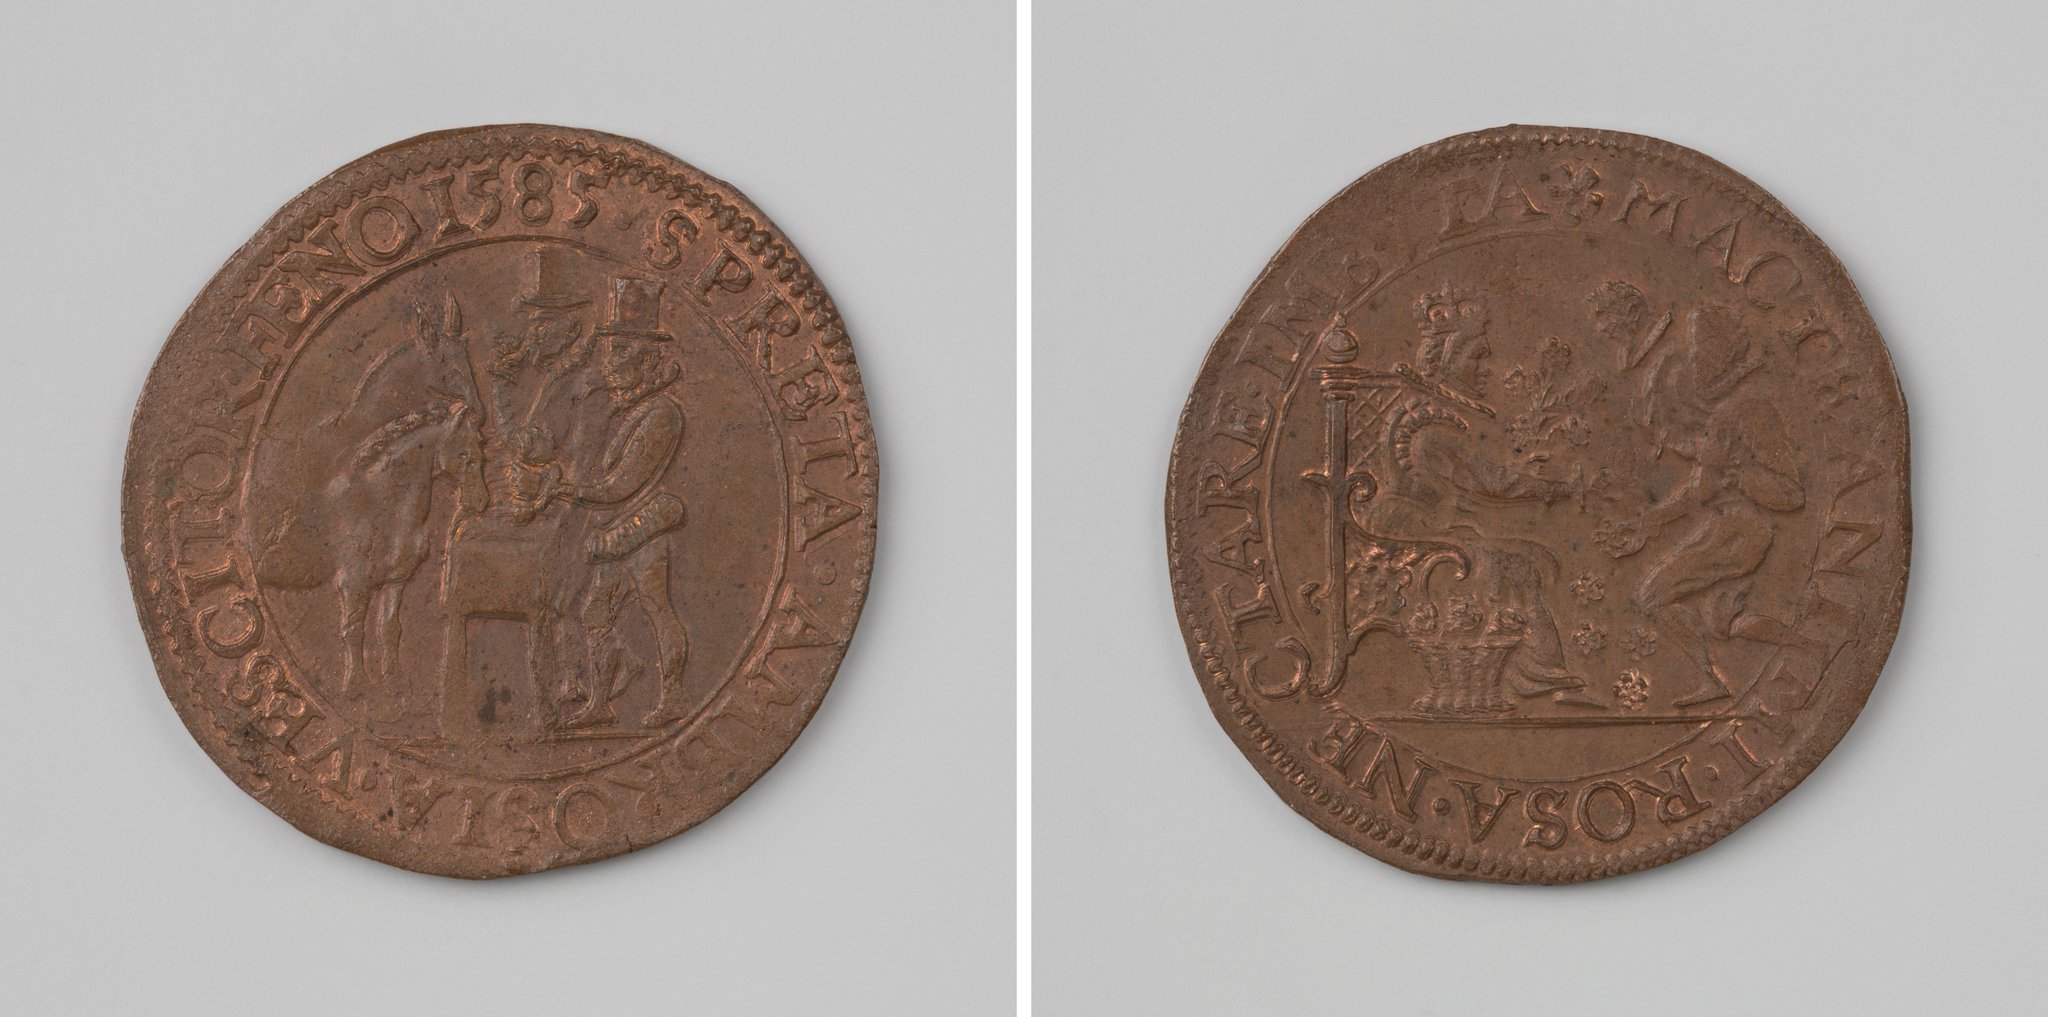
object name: satirical medal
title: Afwijzing van de soevereiniteit over de Verenigde Nederlanden door Engeland en Frankrijk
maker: Anonymous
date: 1585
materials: copper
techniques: striking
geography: dordrecht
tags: greenwich, richmond (surrey), koningin, elizabeth i tudor (koningin van engeland), tachtigjarige oorlog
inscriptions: circumscription: ‘SPRETA AMBROSIA VERCITOR FENO 1585’, circumscription: ‘MACTE ANIMI ROSA NECTARE IMBVTA’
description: Koperen penning. Voorzijde: twee mannen eten hooi met een ezel en een paard binnen omschrift. Keerzijde: zittende vrouw, voorstellende Elisabeth, koningin van Engeland, geeft rozen aan twee Staatse afgezanten binnen omschrift